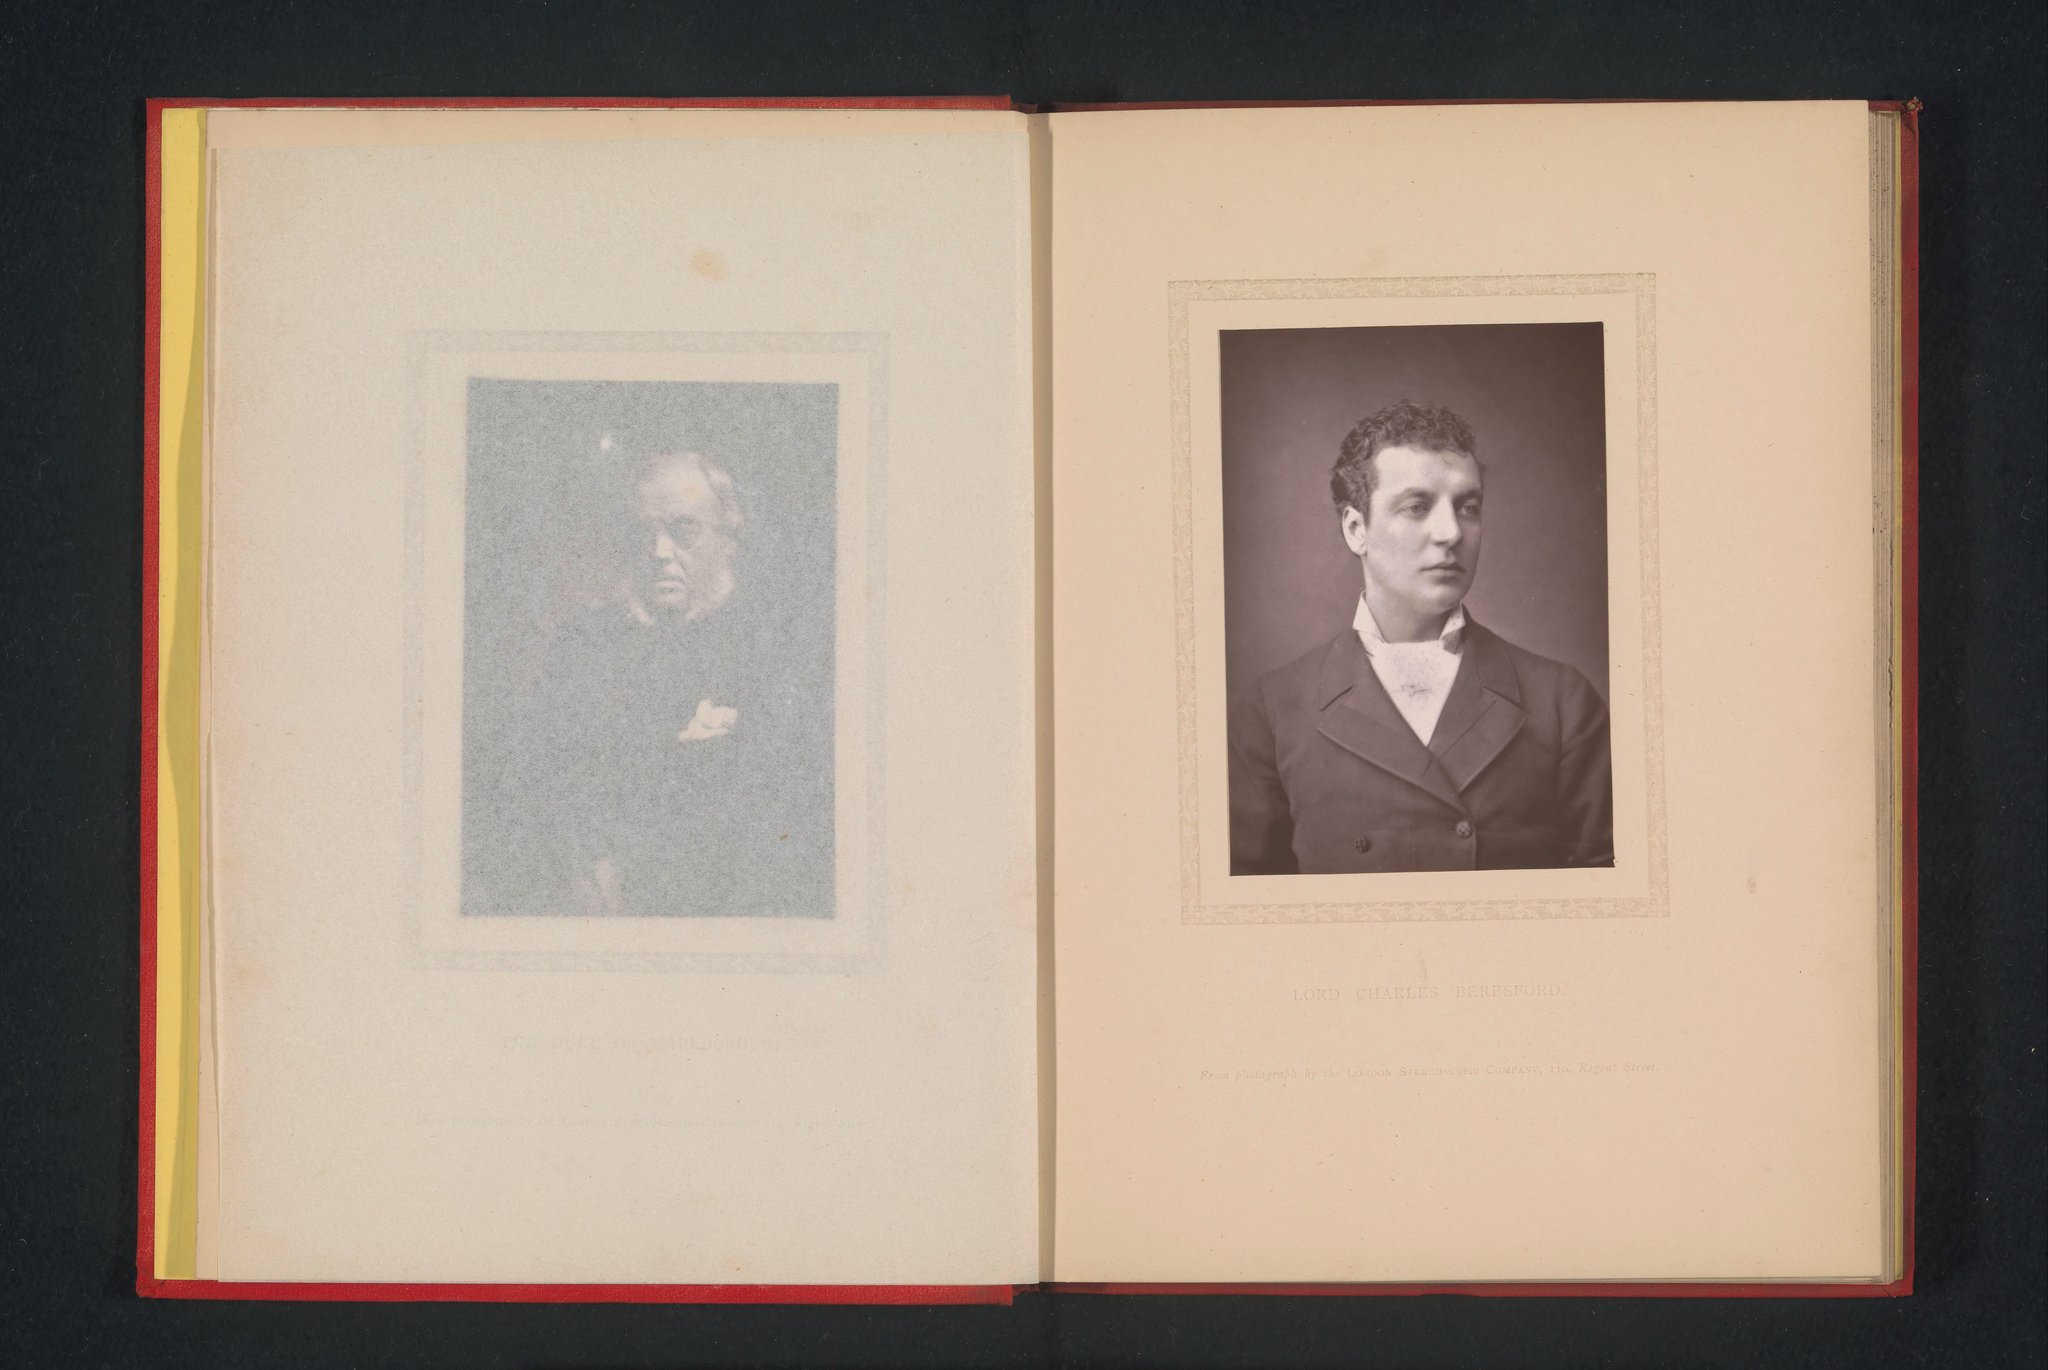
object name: photomechanical print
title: Lord Charles Beresford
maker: Anonymous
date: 1871-1881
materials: paper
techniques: woodburytype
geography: london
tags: politician, e.g. party leader